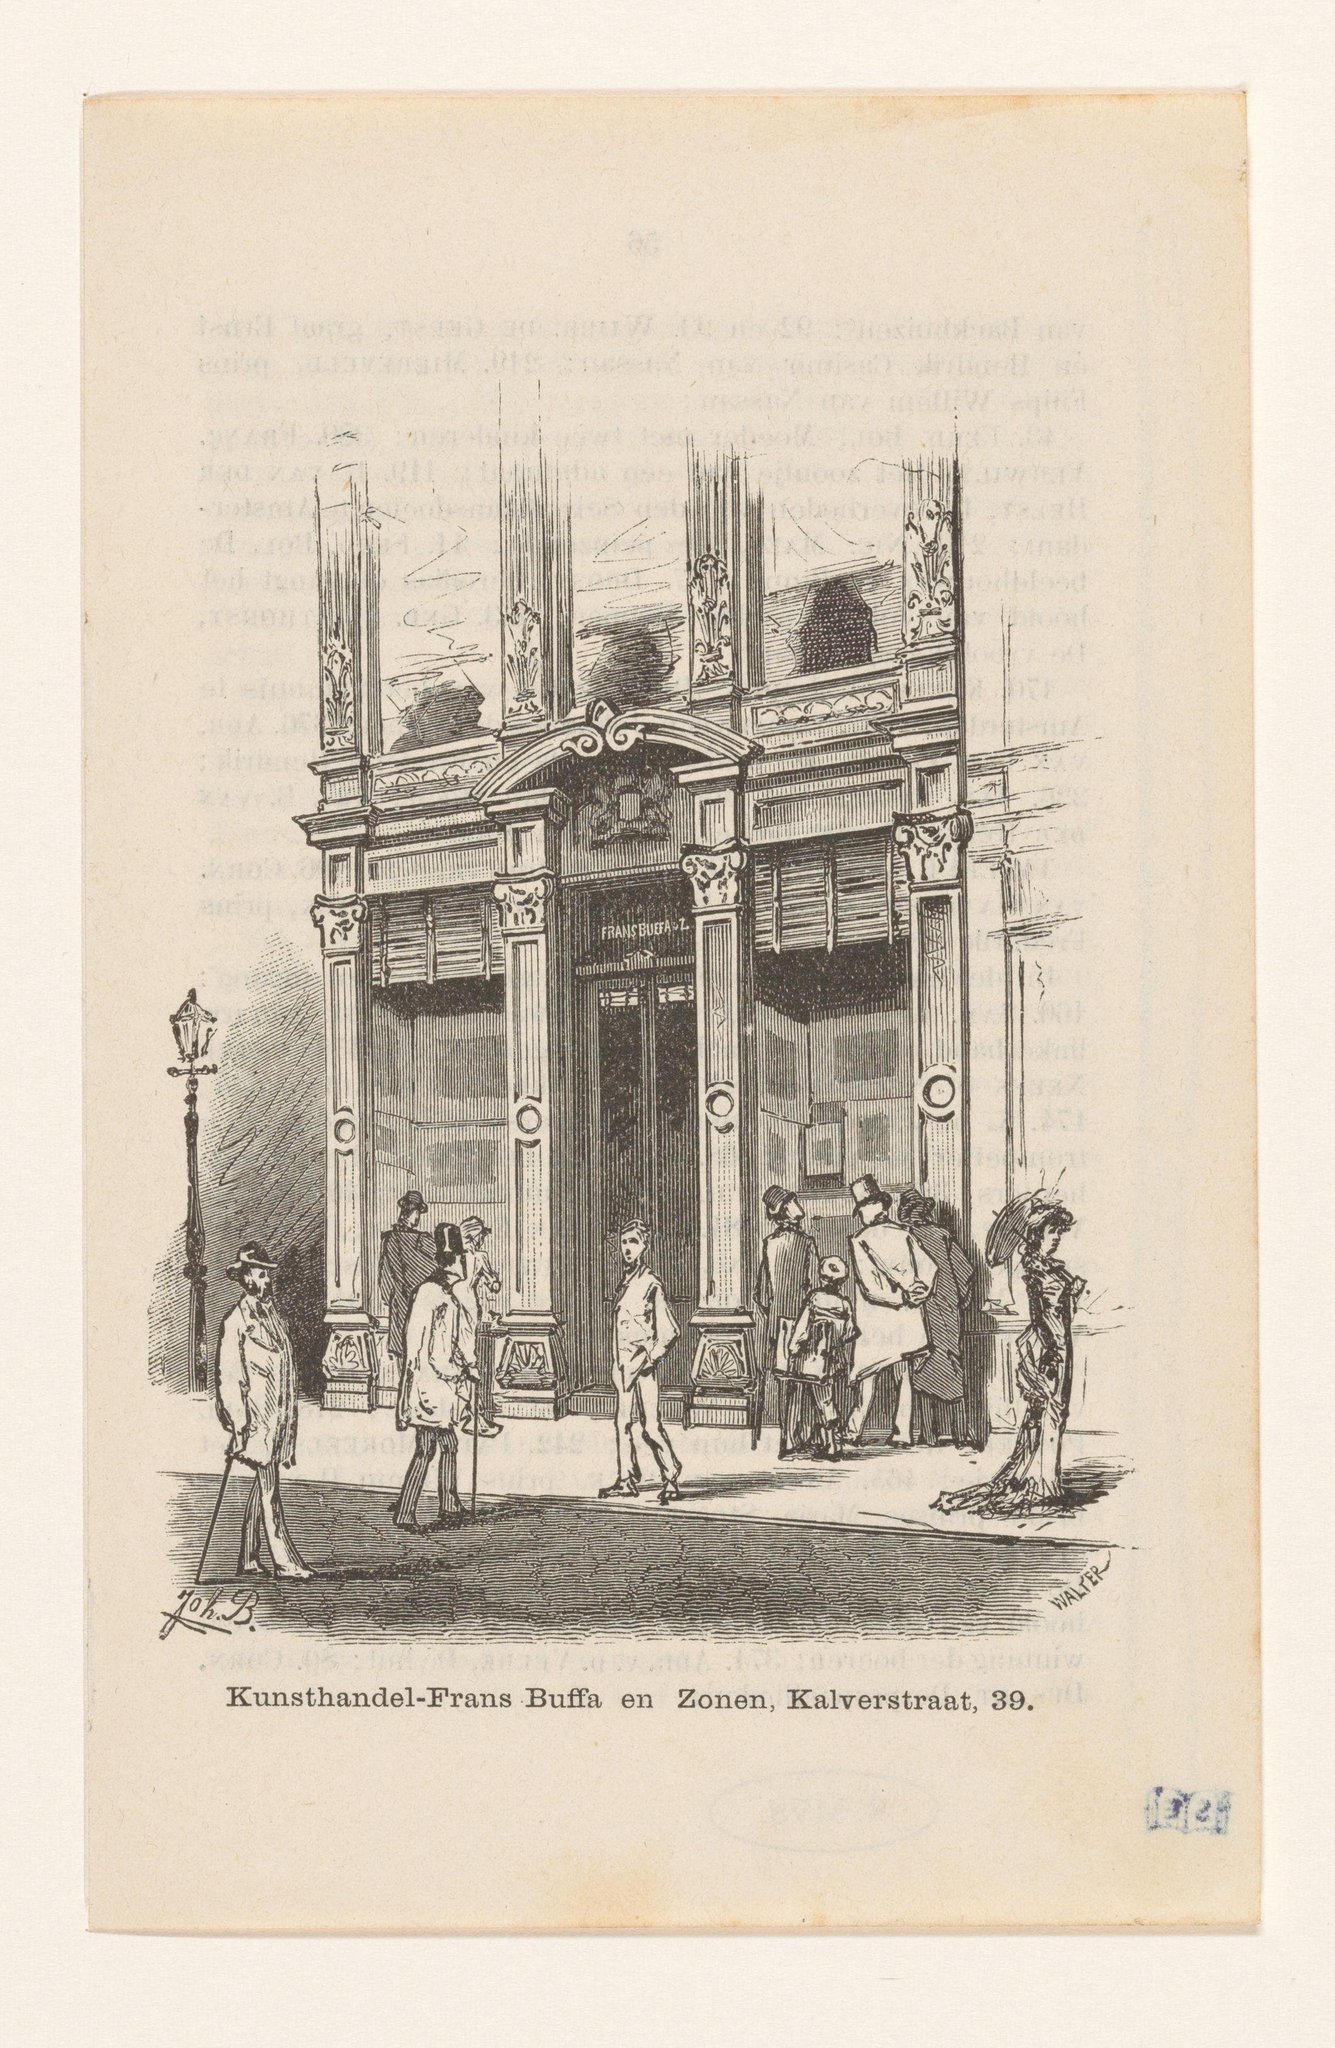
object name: book illustration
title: Etalage van kunsthandel Frans Buffa in de Kalverstraat te Amsterdam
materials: paper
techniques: engraving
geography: amsterdam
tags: art dealer, façade (of house or building), shop-window, show-window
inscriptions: collector's mark: Lugt 4780, collector's mark: Lugt 2228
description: Prent mogelijk afkomstig uit: Geïllustreerde gids van Amsterdam. Amsterdam: Van Holkema en Warendorf, [1892].